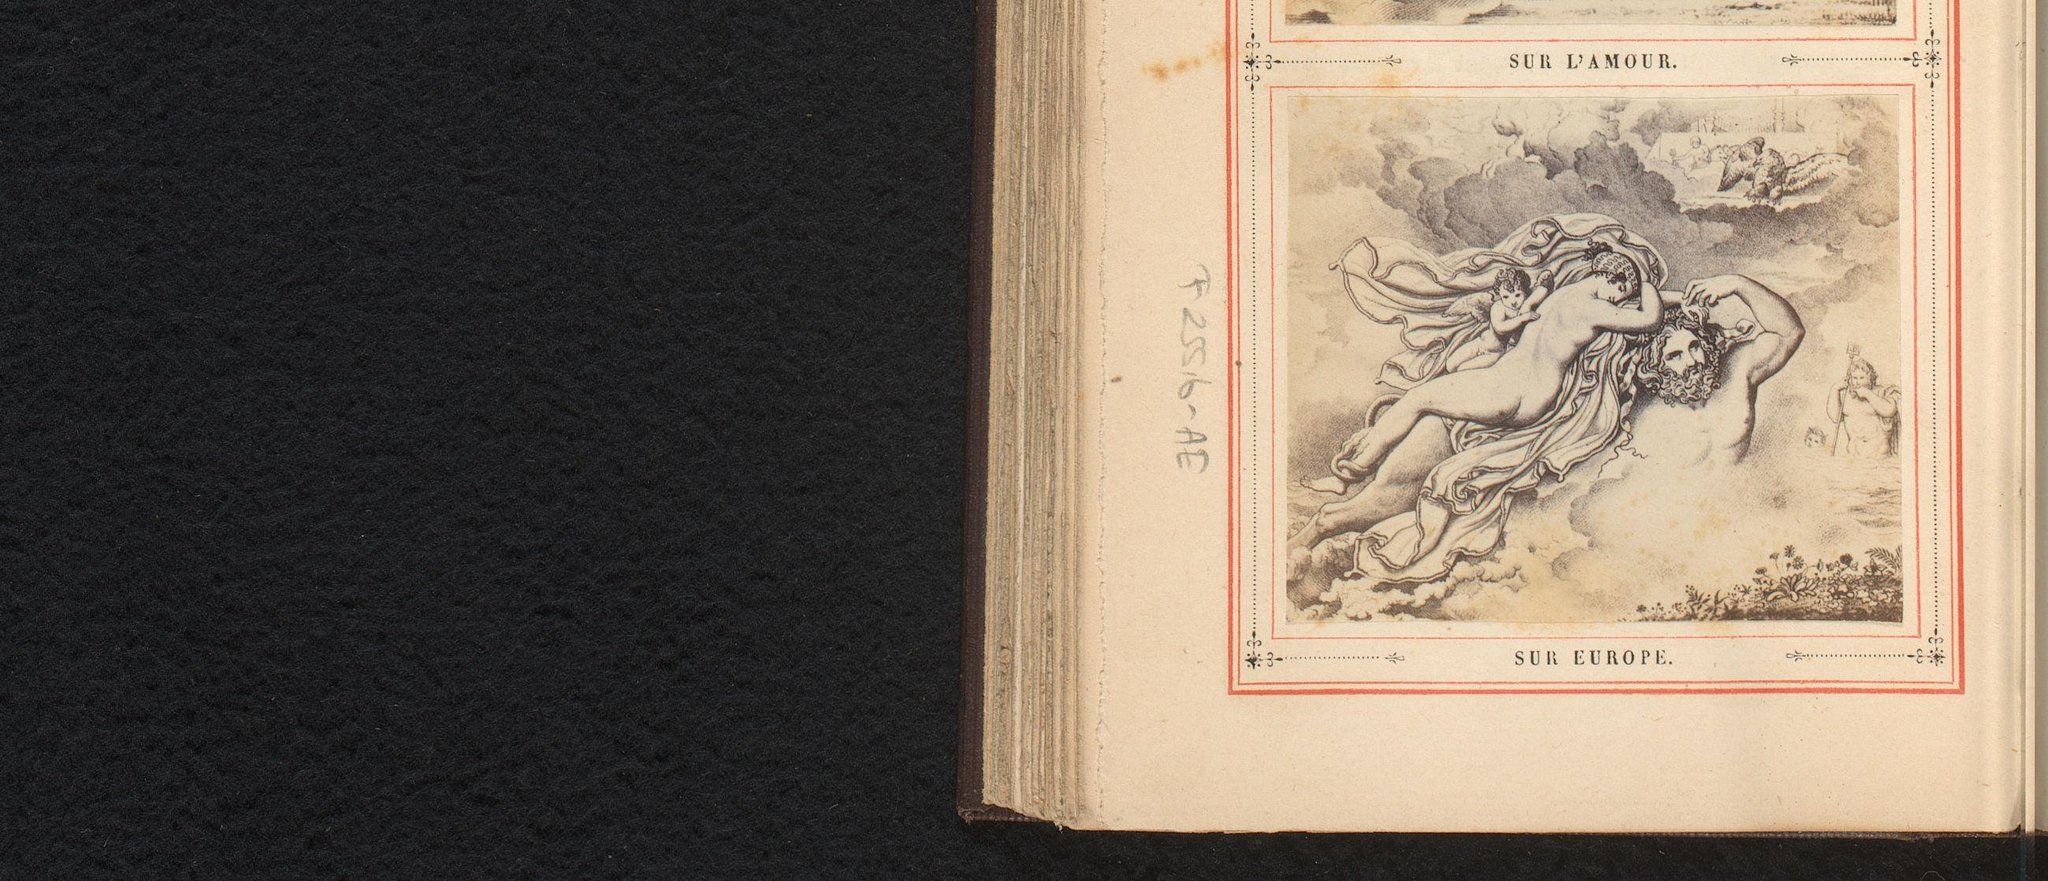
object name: page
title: Sur Europe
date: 1859-1864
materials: paper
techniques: albumen print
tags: gods ~ classical mythology